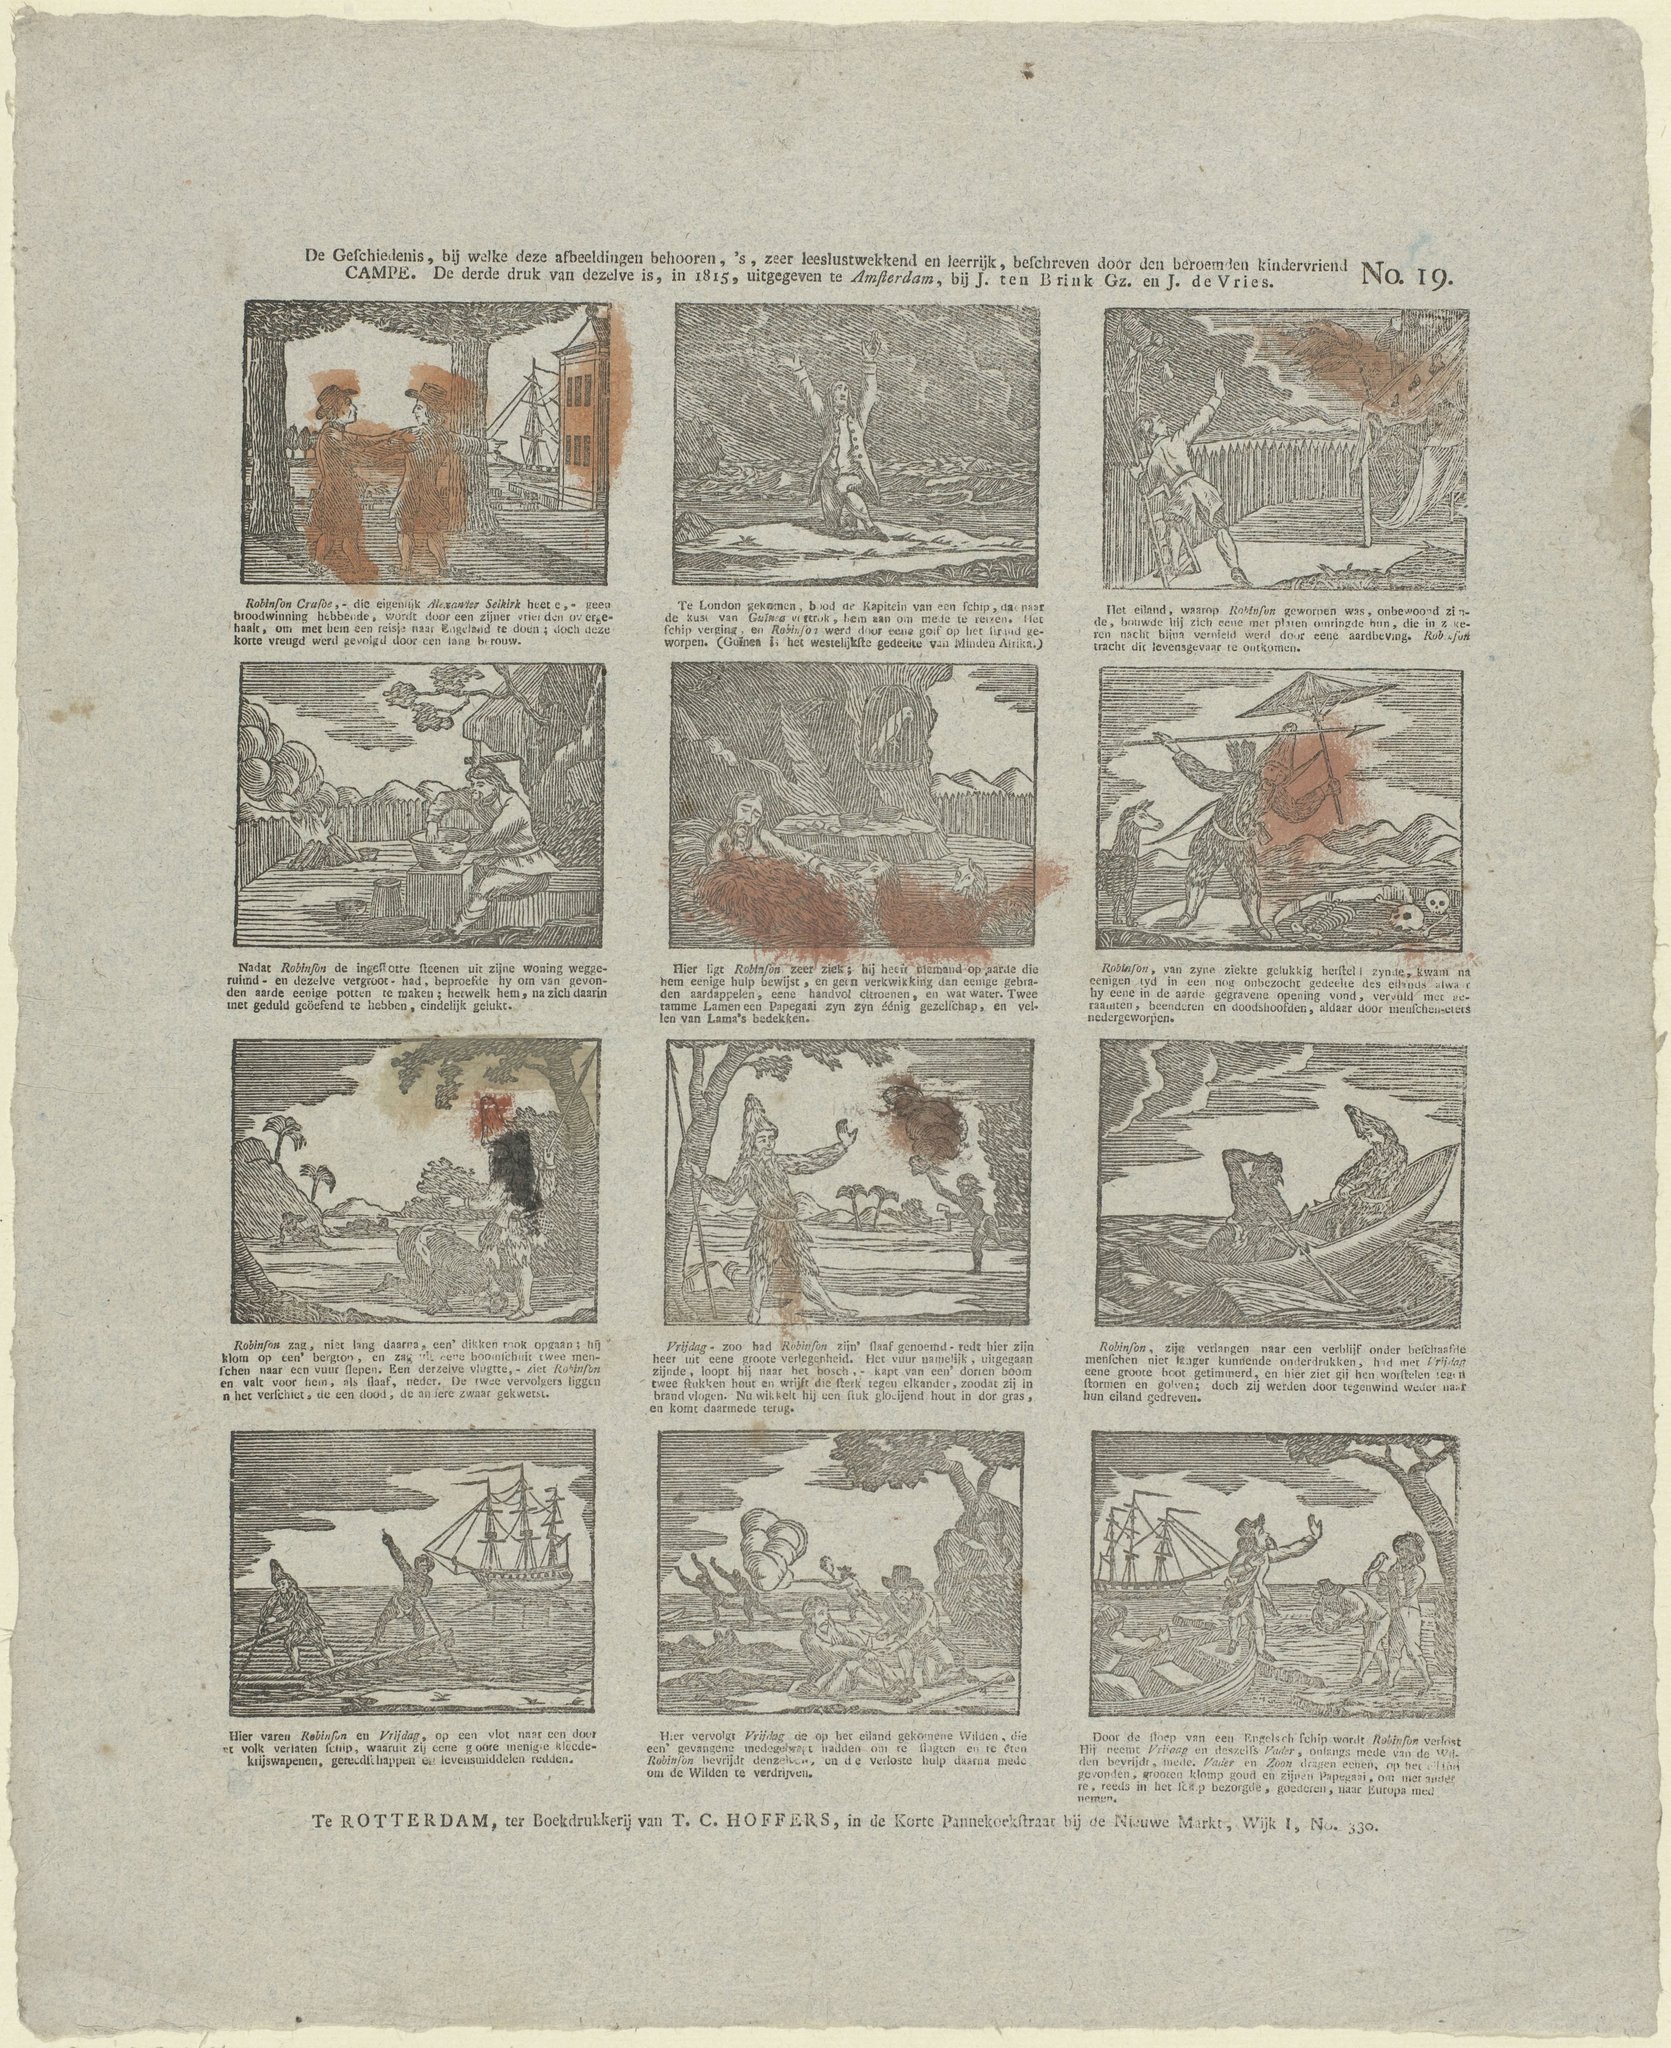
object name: popular print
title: De geschiedenis, bij welke deze afbeeldingen behooren, is, zeer leeslustwekkend en leerrijk, beschreven door den beroemden kindervriend / Camp (...)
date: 1820-1838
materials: paper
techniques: colour, letterpress printing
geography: rotterdam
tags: (scenes from) specific works of literature: defoe, robinson crusoe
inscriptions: collector's mark: Lugt 2760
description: Blad met 12 voorstellingen uit het verhaal van Robinson Crusoe die strandt op een eiland. Onder elke afbeelding een onderschrift. Genummerd rechtsboven: No. 19.